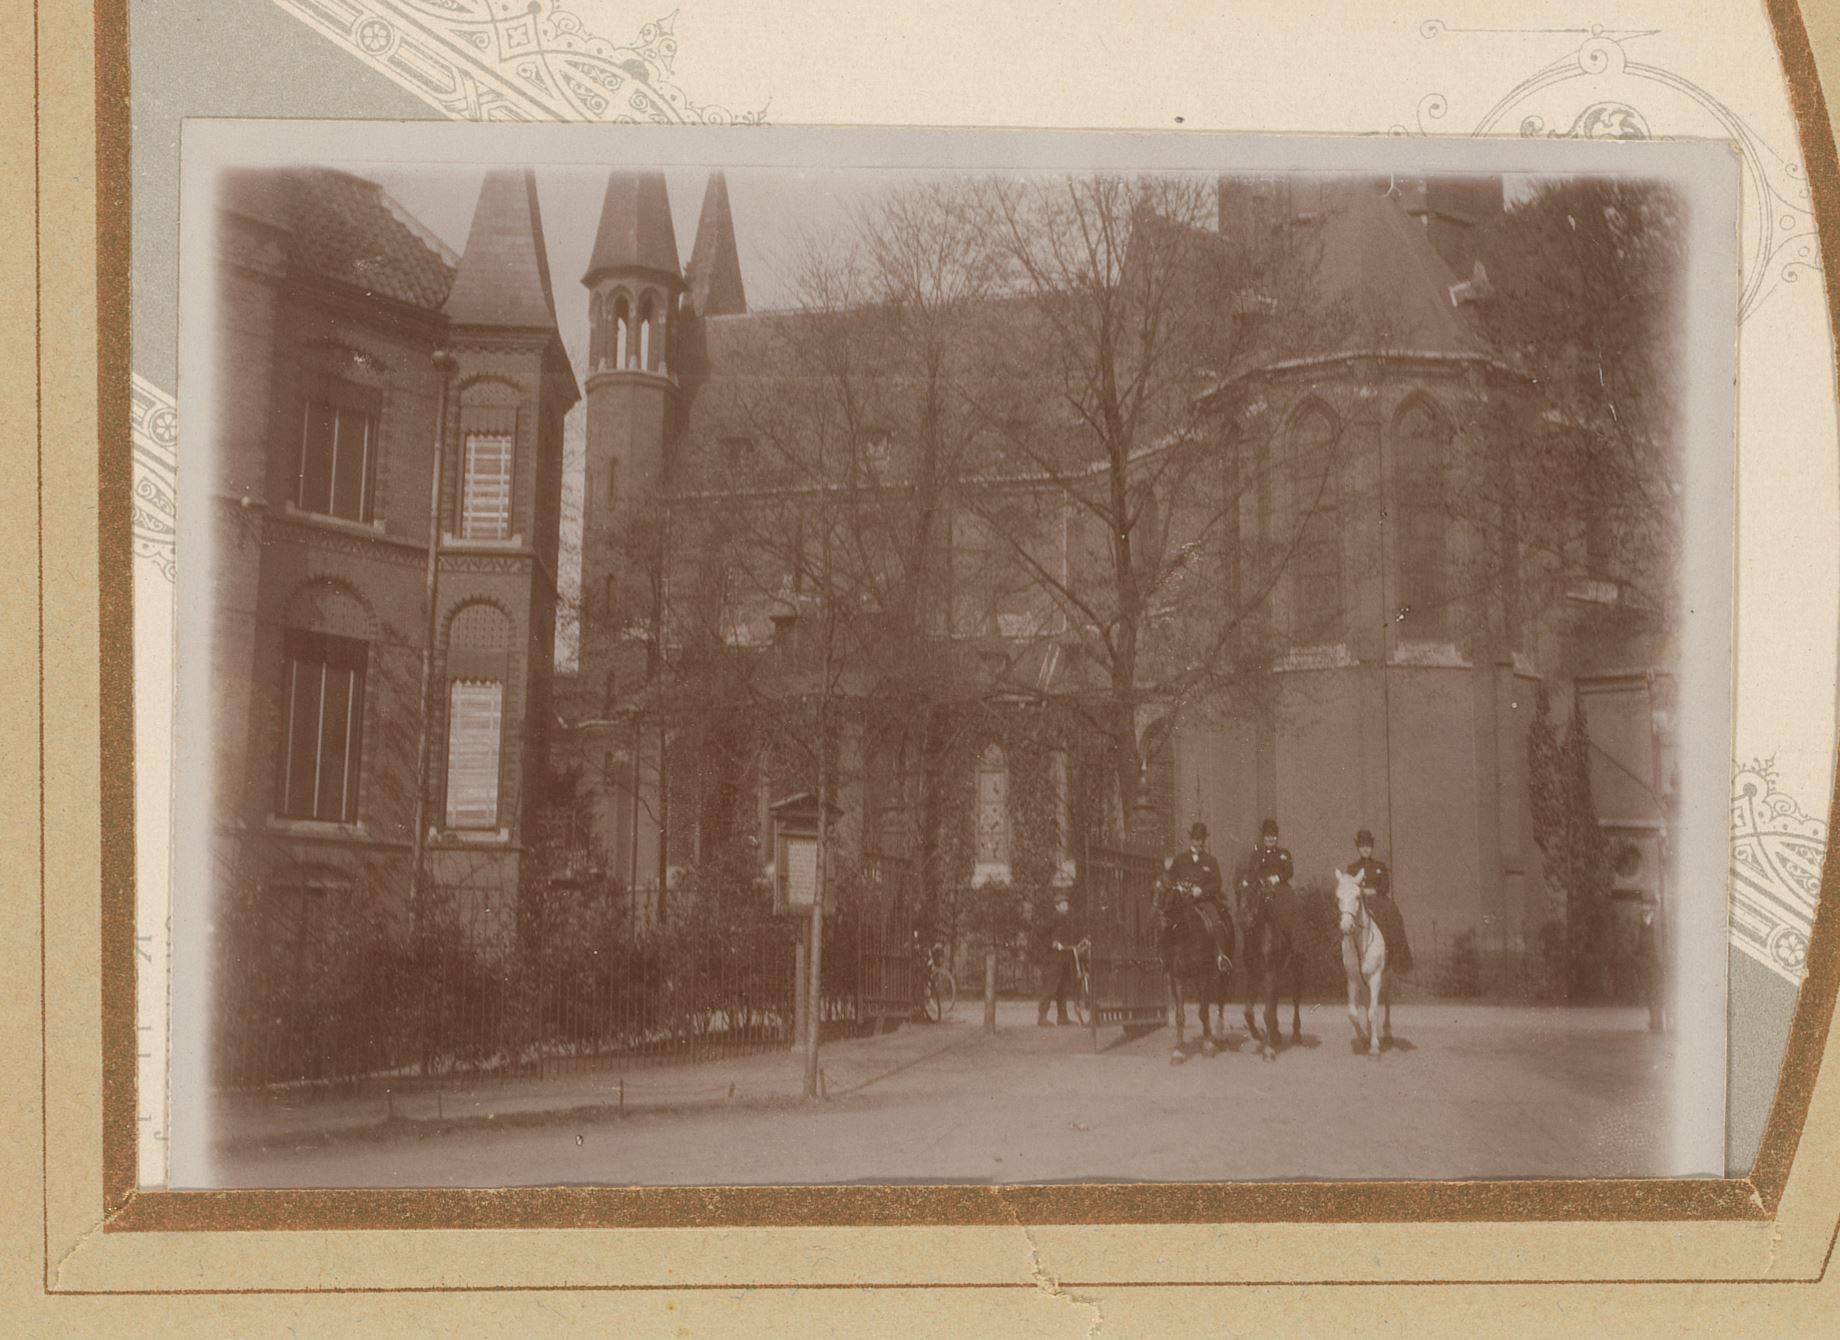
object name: album leaf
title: Straatgezicht met drie mannen te paard bij neogotische kerk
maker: Anonymous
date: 1890-1920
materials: photographic support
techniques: collodion silver print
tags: riding a horse, ass, or mule; rider, horseman, church (exterior), street (+ city(-scape) with figures, staffage)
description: Twee mannen en een vrouw te paard bij de ingang van het Vondelpark te Amsterdam. Op de achtergrond de Vondelstraat met de Vondelkerk. Deze foto maakt deel uit van een album.